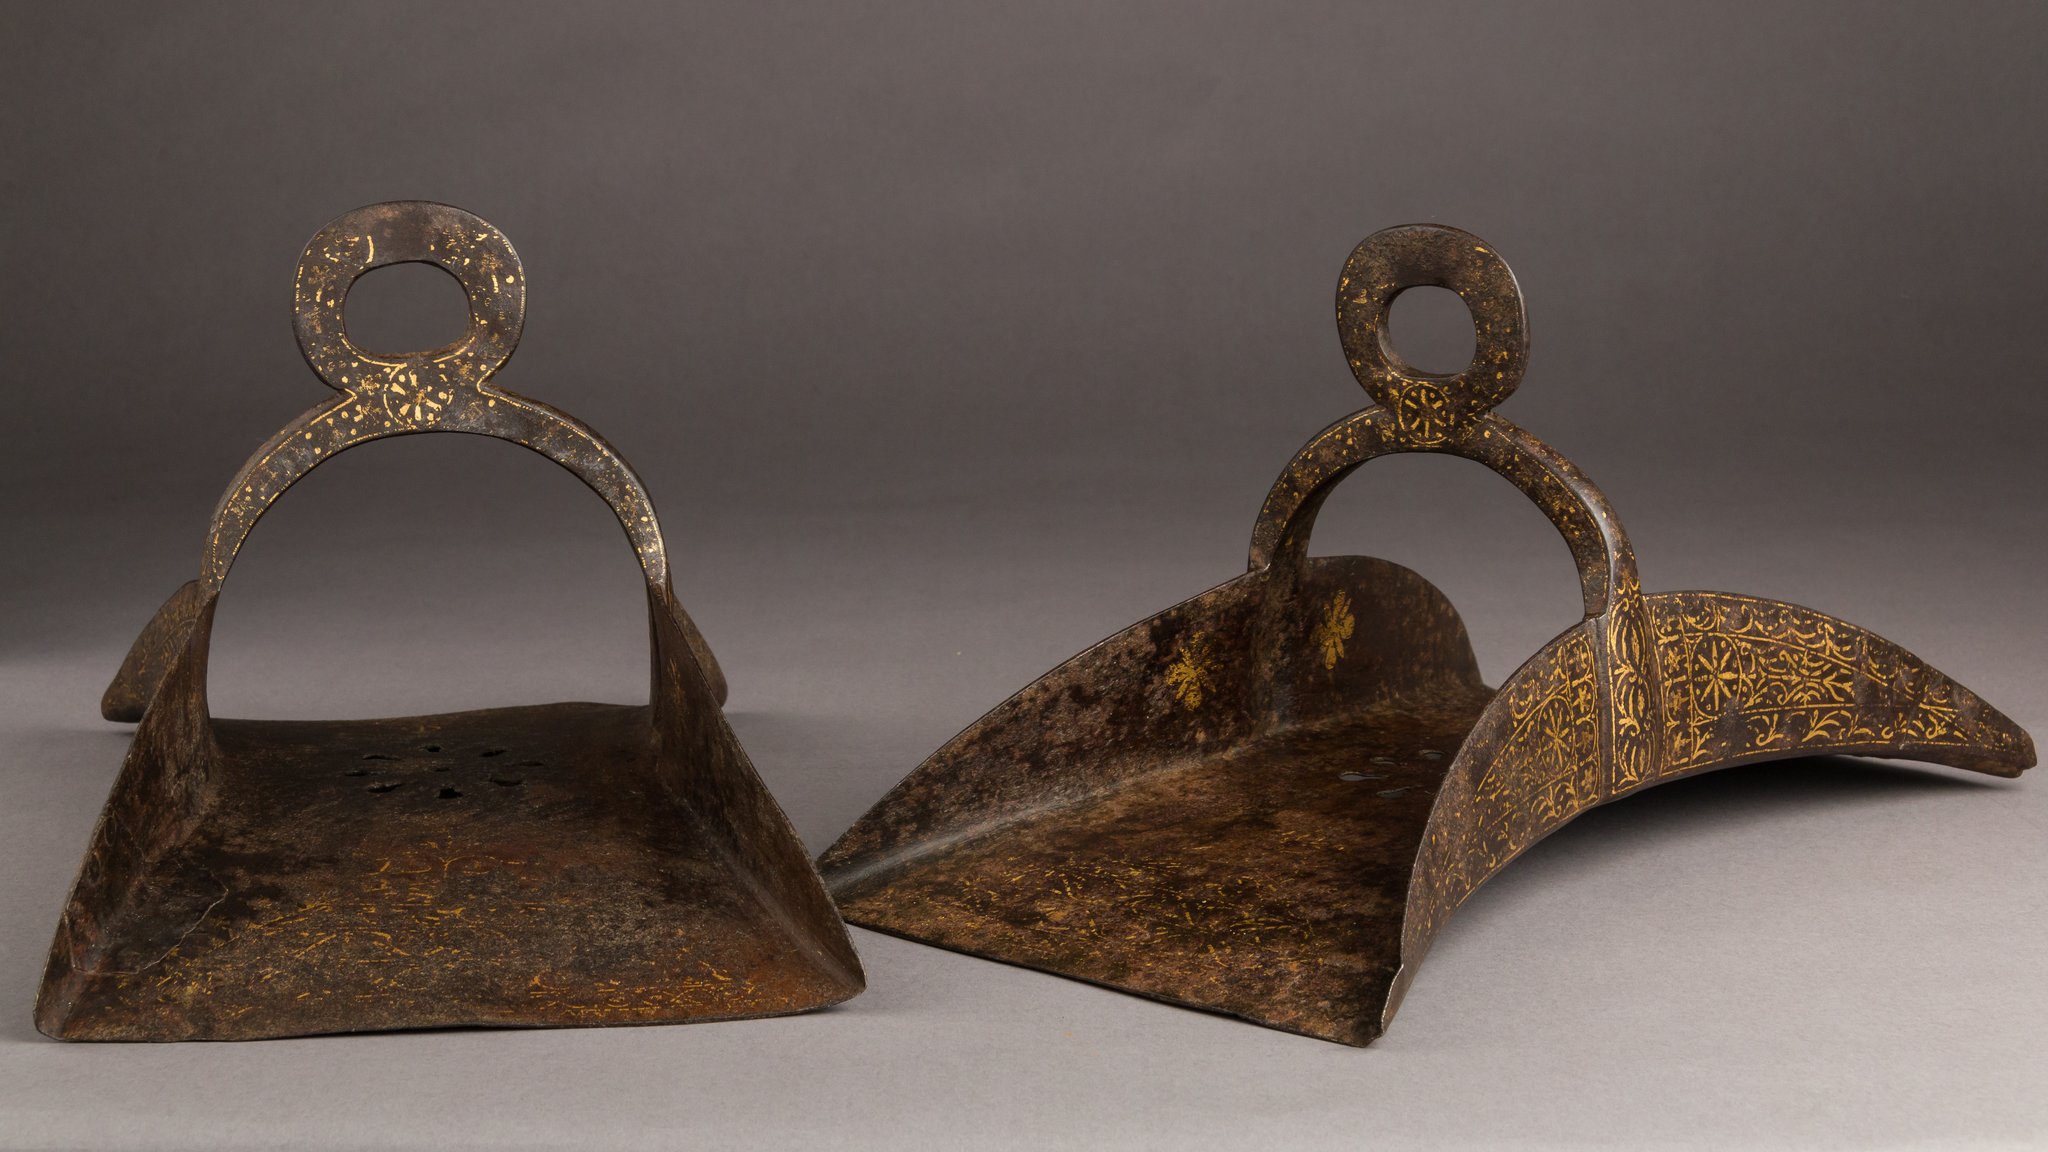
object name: stirrup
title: Pair of Stirrups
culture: mamluk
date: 1701-1800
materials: gold, iron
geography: egypt